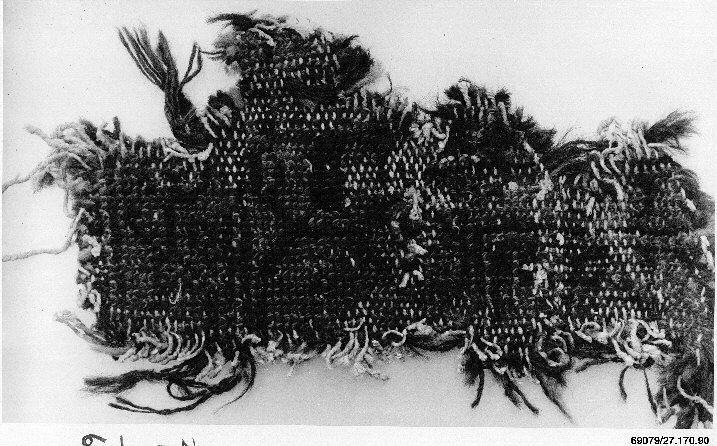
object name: carpet fragment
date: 1301-1500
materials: cotton, wool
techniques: pile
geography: turkey